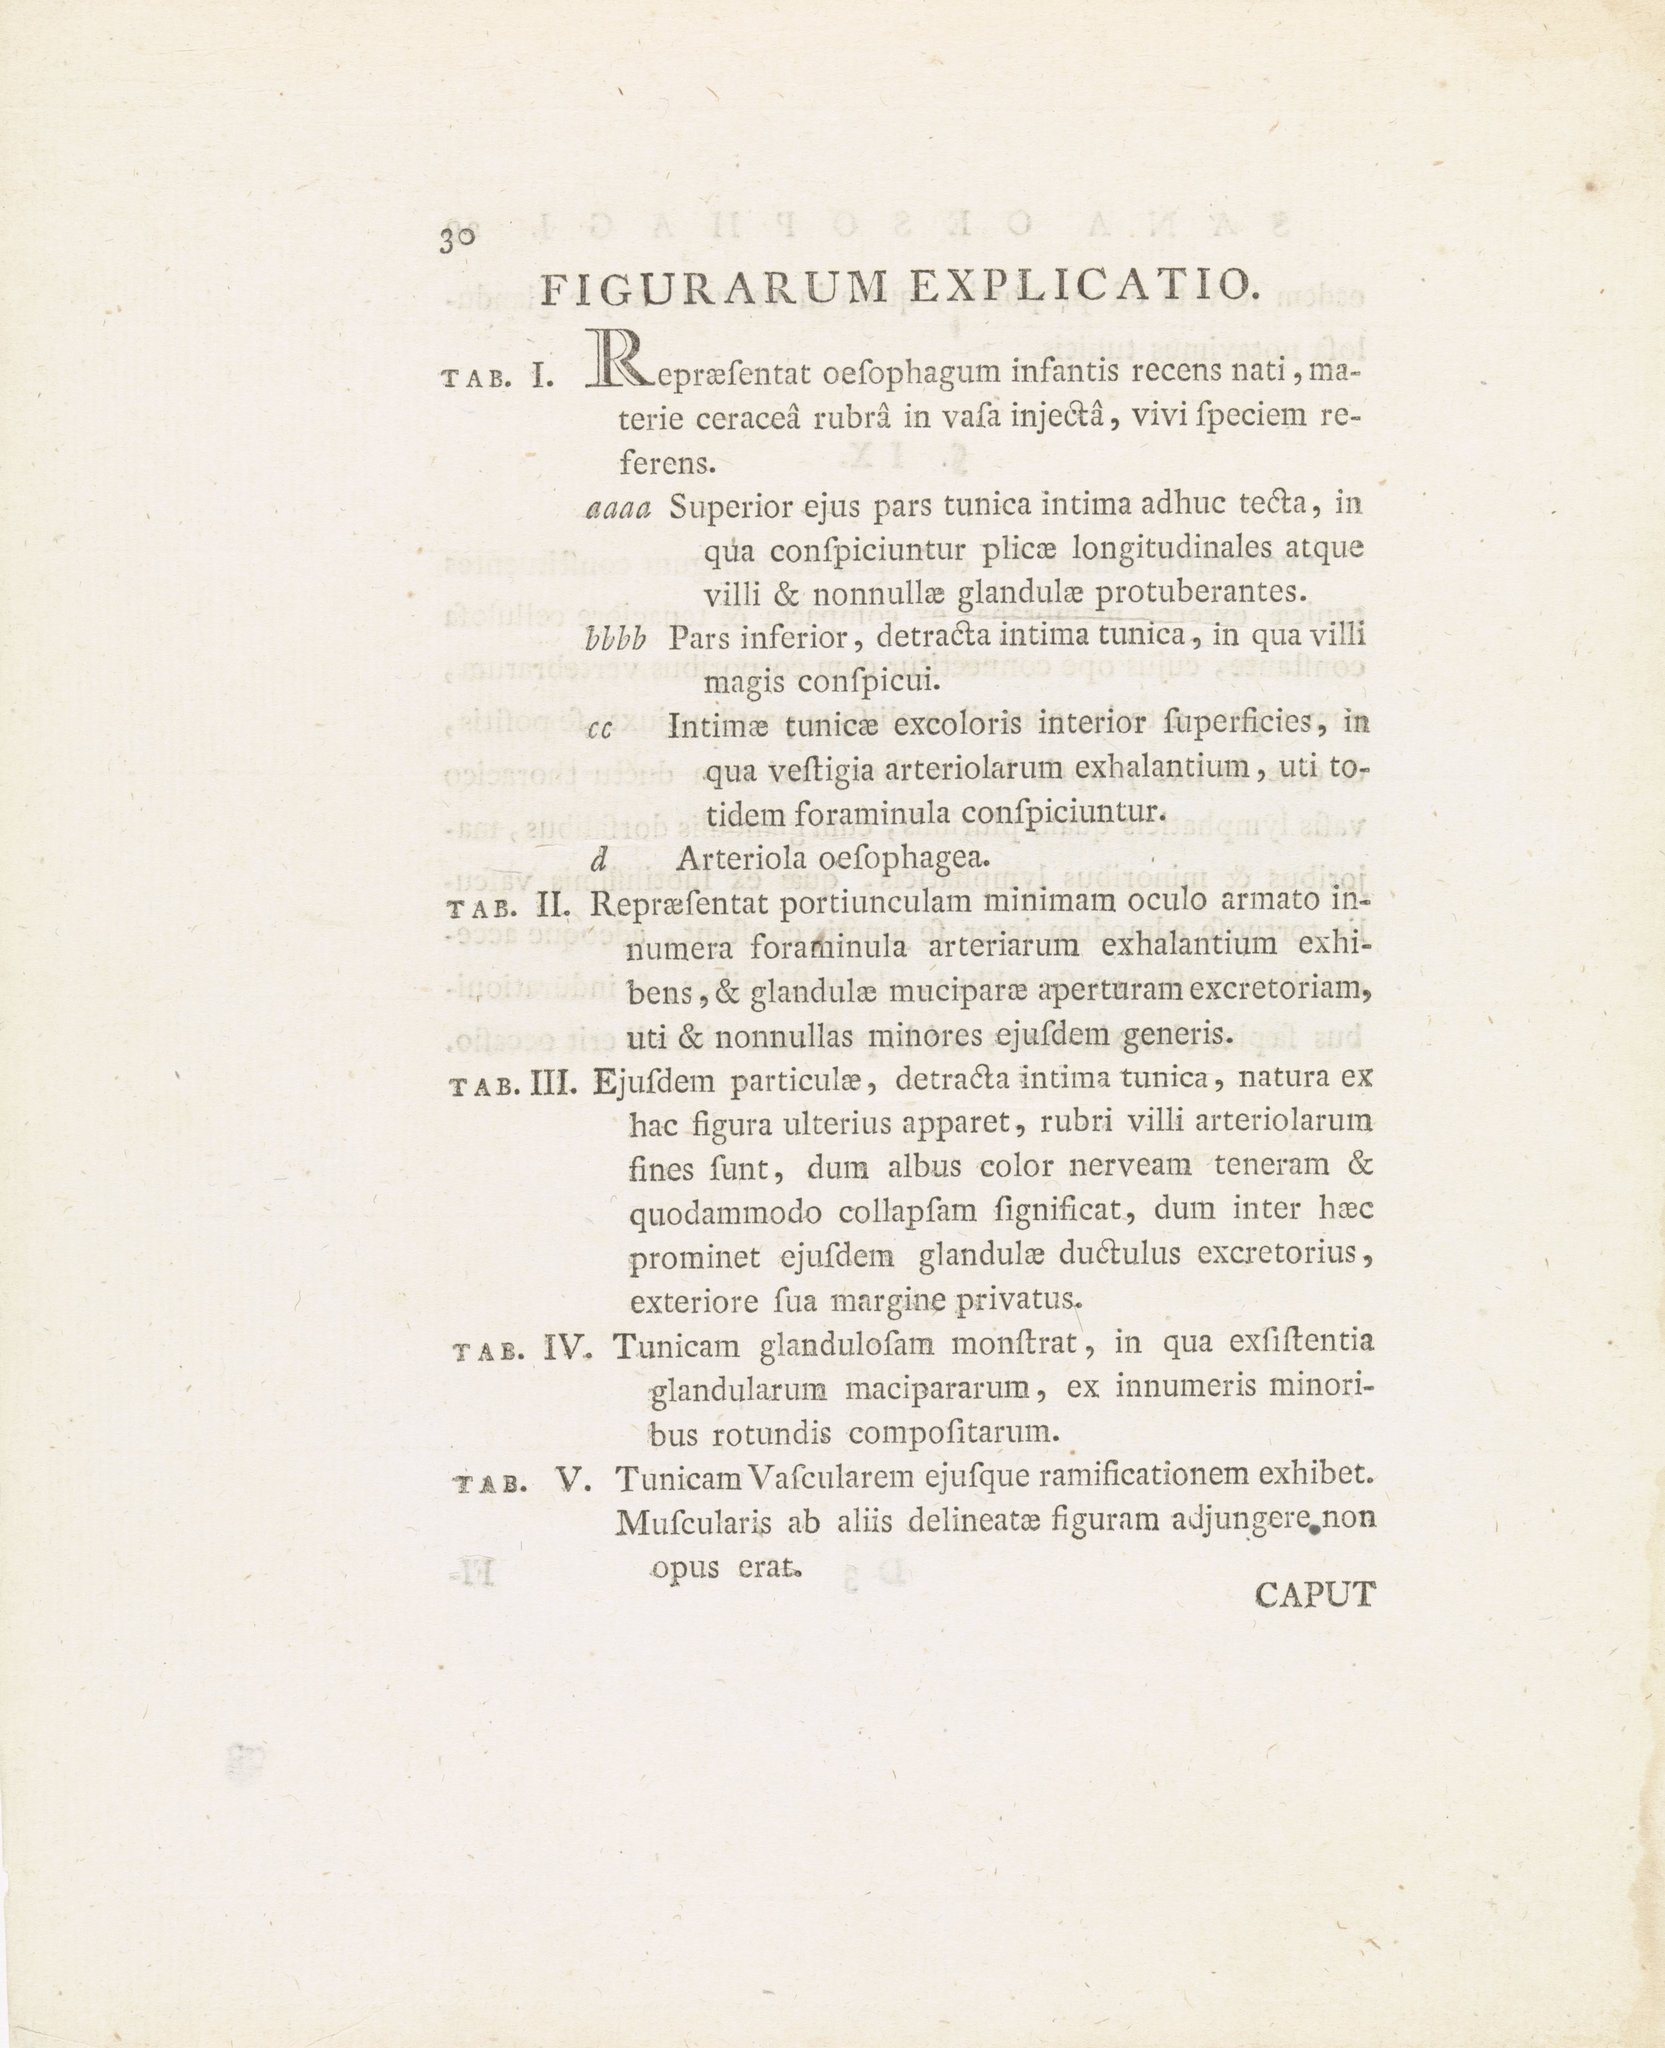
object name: text sheet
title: Tekstblad uit: Janus Bleuland, Observationes Anatomico-Medicae de Sana et Morbosa Oesophagi Structura, 1785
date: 1785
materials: paper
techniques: letterpress printing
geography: leiden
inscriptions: collector's mark: Lugt 2228, collector's mark: Lugt 2760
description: Pagina 29 en 30 uit: Janus Bleuland, Observationes Anatomico-Medicae de Sana et Morbosa Oesophagi Structura, 1785. Blad op beide zijden bedrukt.